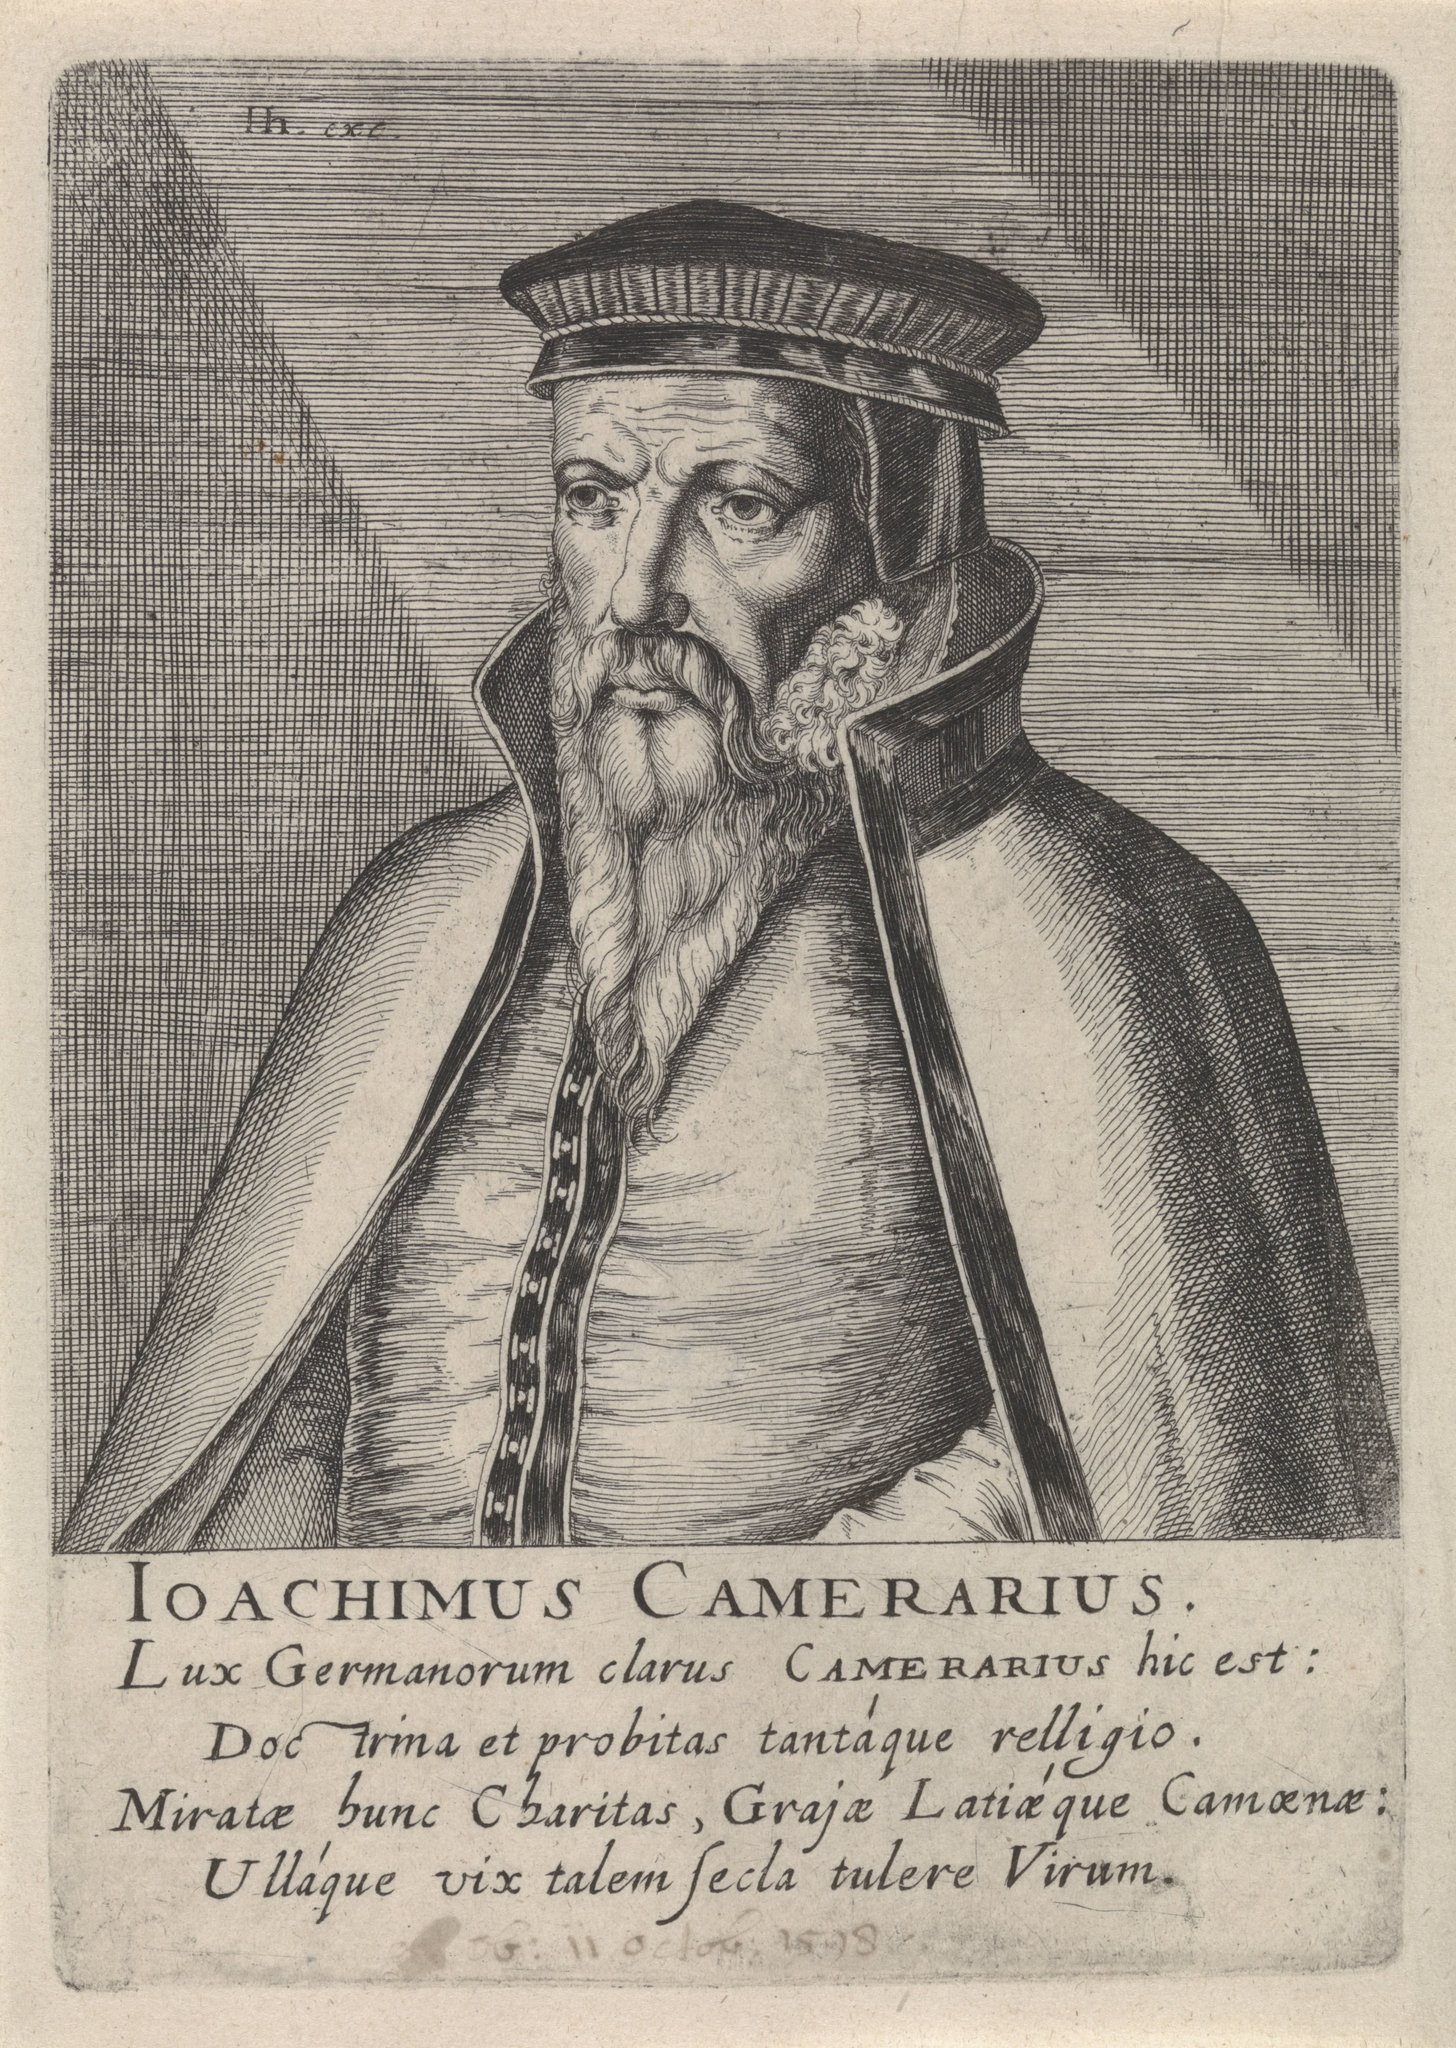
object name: print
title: Beroemde hervormers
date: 1610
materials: paper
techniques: etching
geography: the hague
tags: joachim camerarius (i)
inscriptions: collector's mark: Lugt 2228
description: Buste naar links van Joachim Camerarius. Onder het portret zijn naam en vier regels in het Latijn. Prent uit het later toegevoegde deel 2 (28 prenten) van de serie portretten van beroemde hervormers door Hendrick Hondius uit 1599.